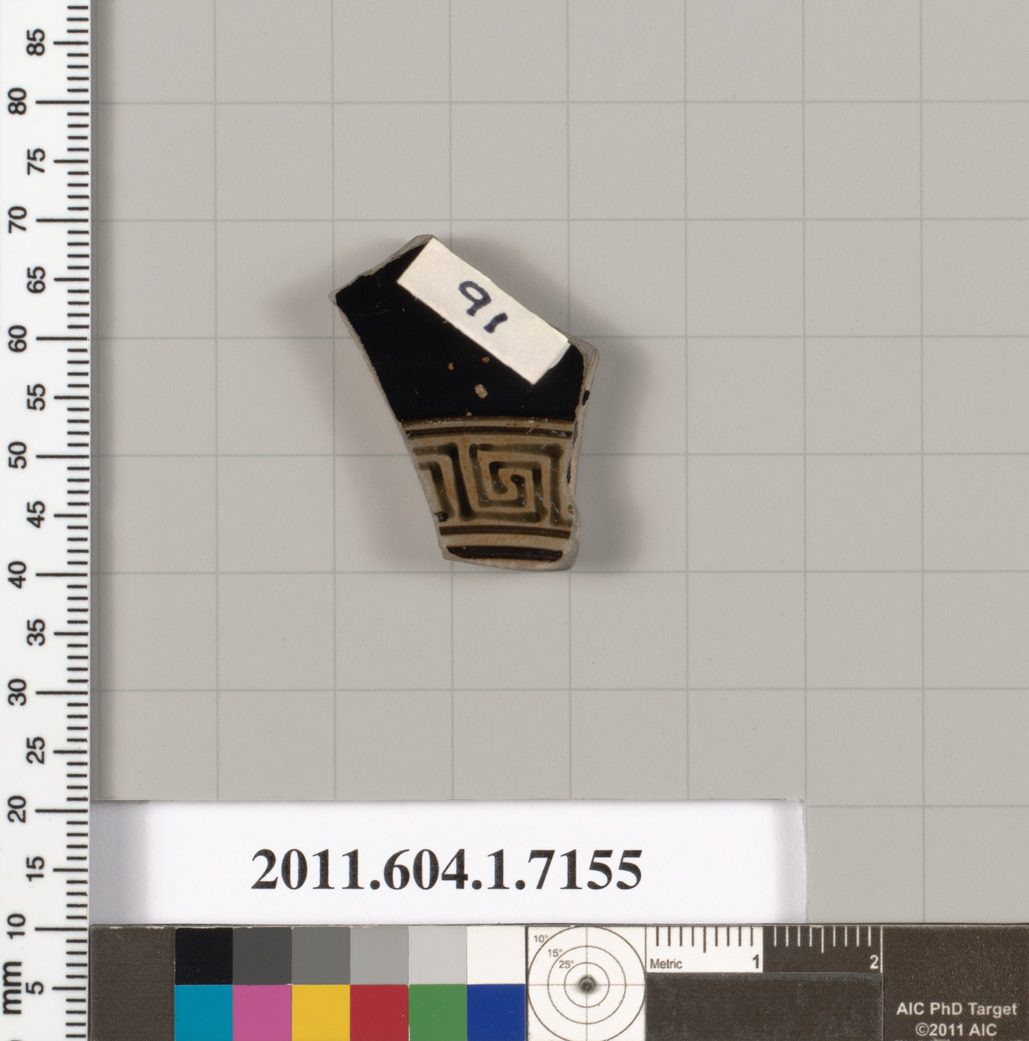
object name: kylix fragment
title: Terracotta fragment of a kylix (drinking cup)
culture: greek, attic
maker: makron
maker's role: artist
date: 500-480 BCE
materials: terracotta